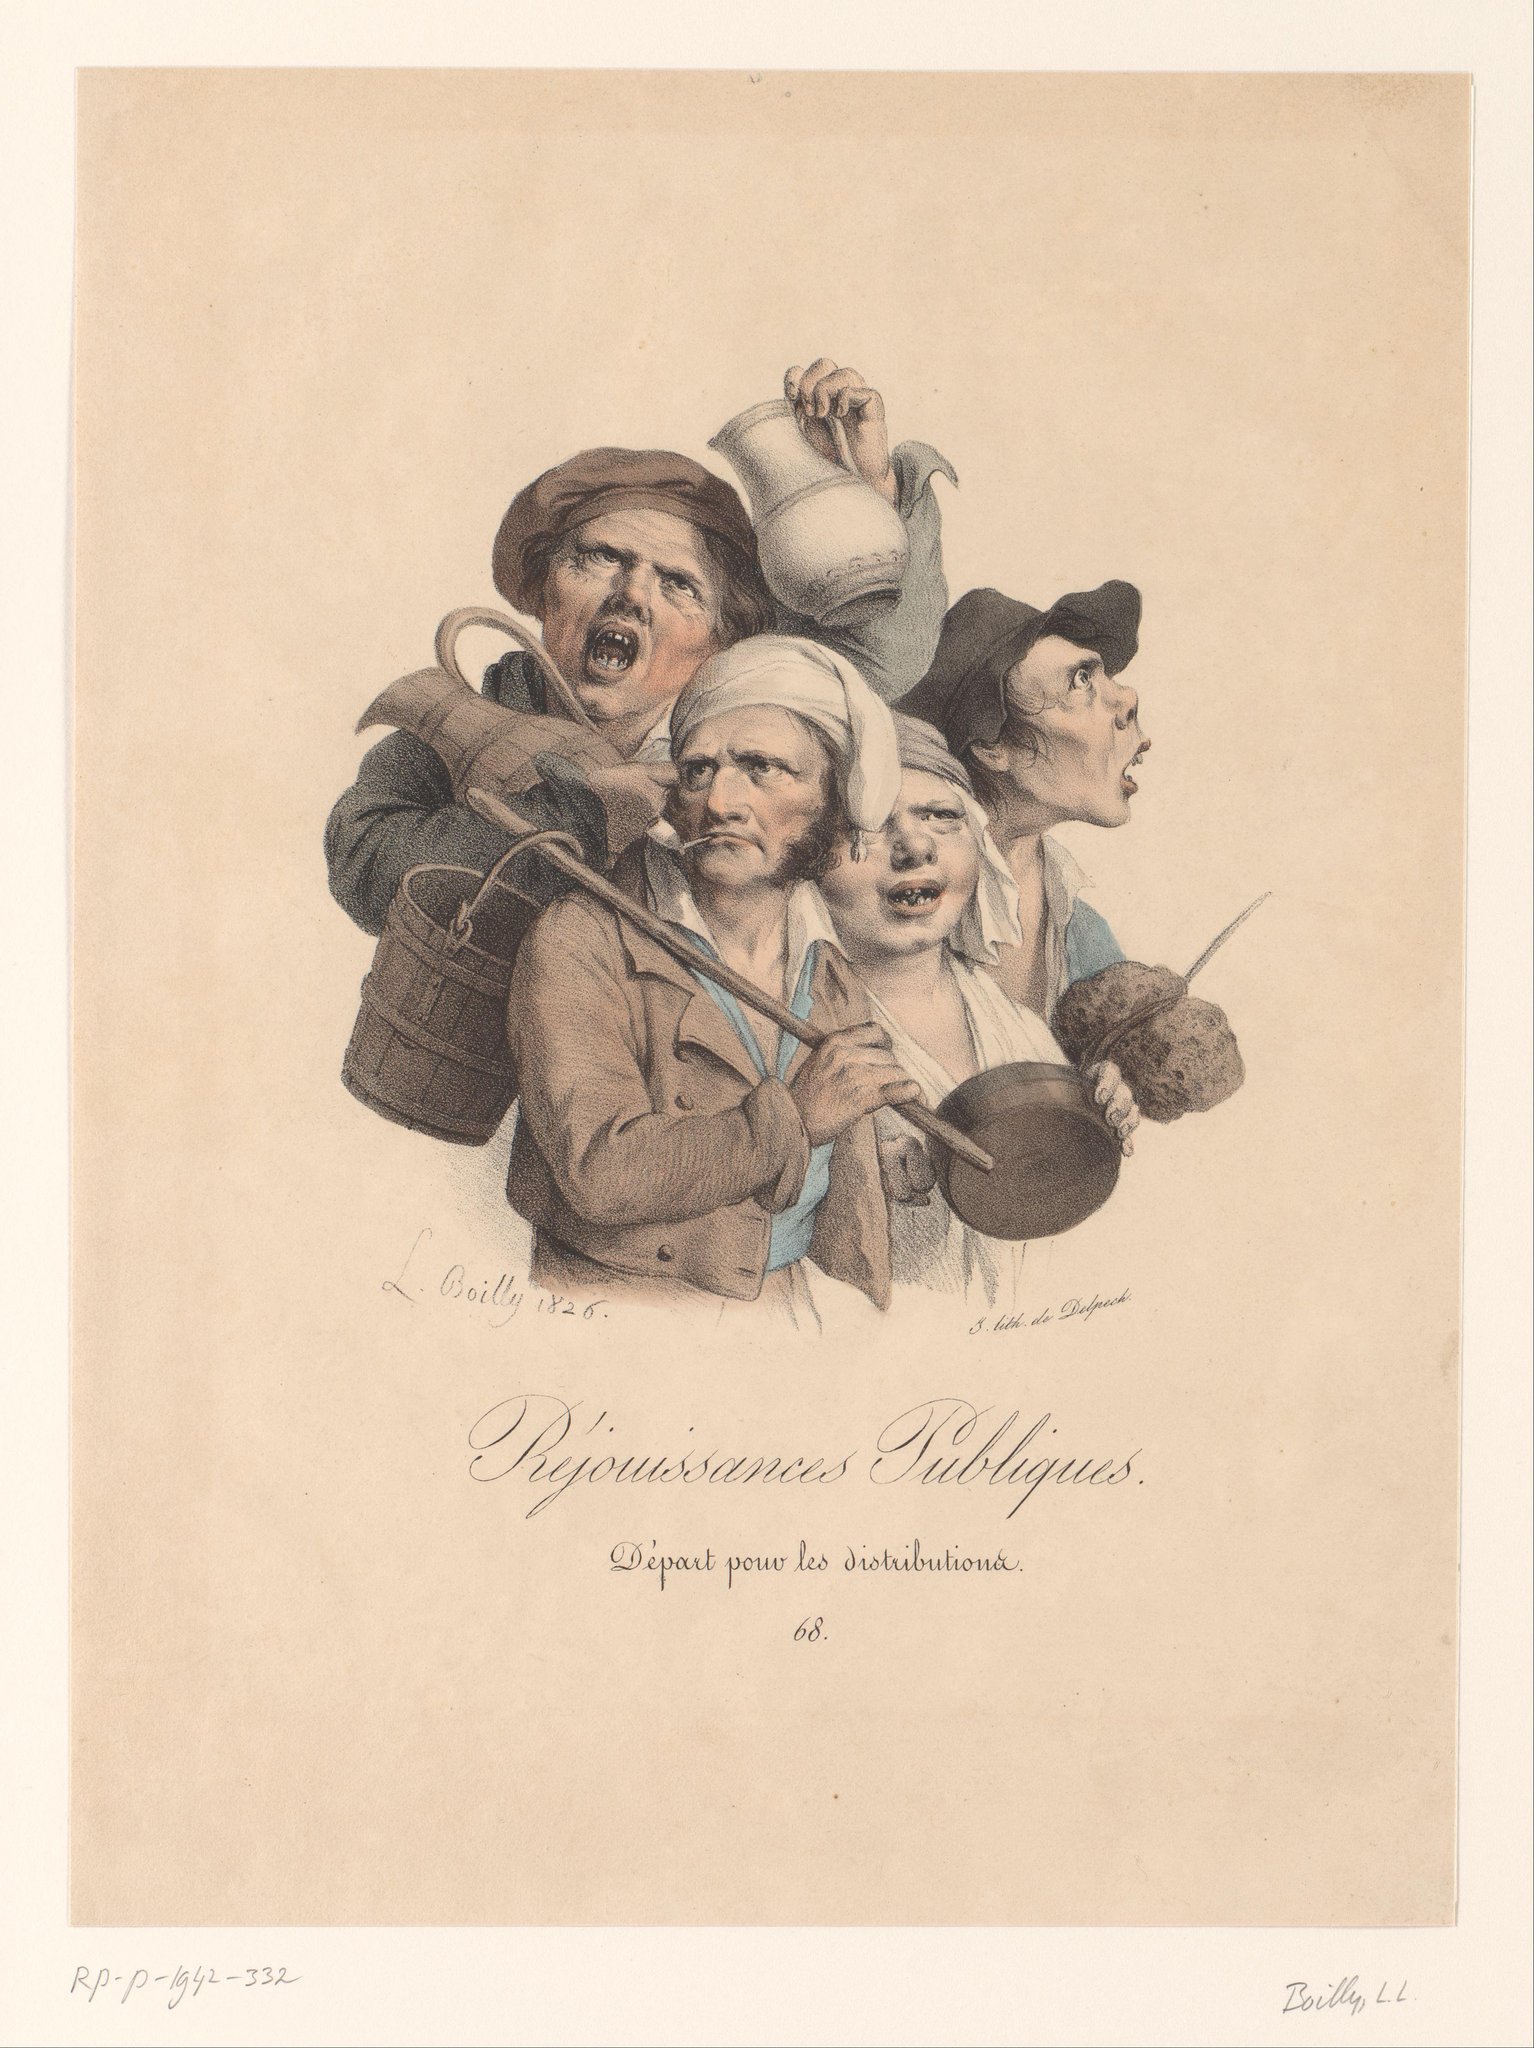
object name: print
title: Gezichten met een grimas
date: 1826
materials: paper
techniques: hand coloring, lithograph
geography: paris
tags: public festivities (+ eating and drinking ~ festive activities), caricatures (human types)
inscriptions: collector's mark: Lugt 2228a, collector's mark: Lugt 2760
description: De mannen en de vrouw hebben emmers, pannen en kruiken bij zich, waarmee ze gratis drank en voedsel (les distributions) gaan ophalen tijdens de openbare festiviteiten.